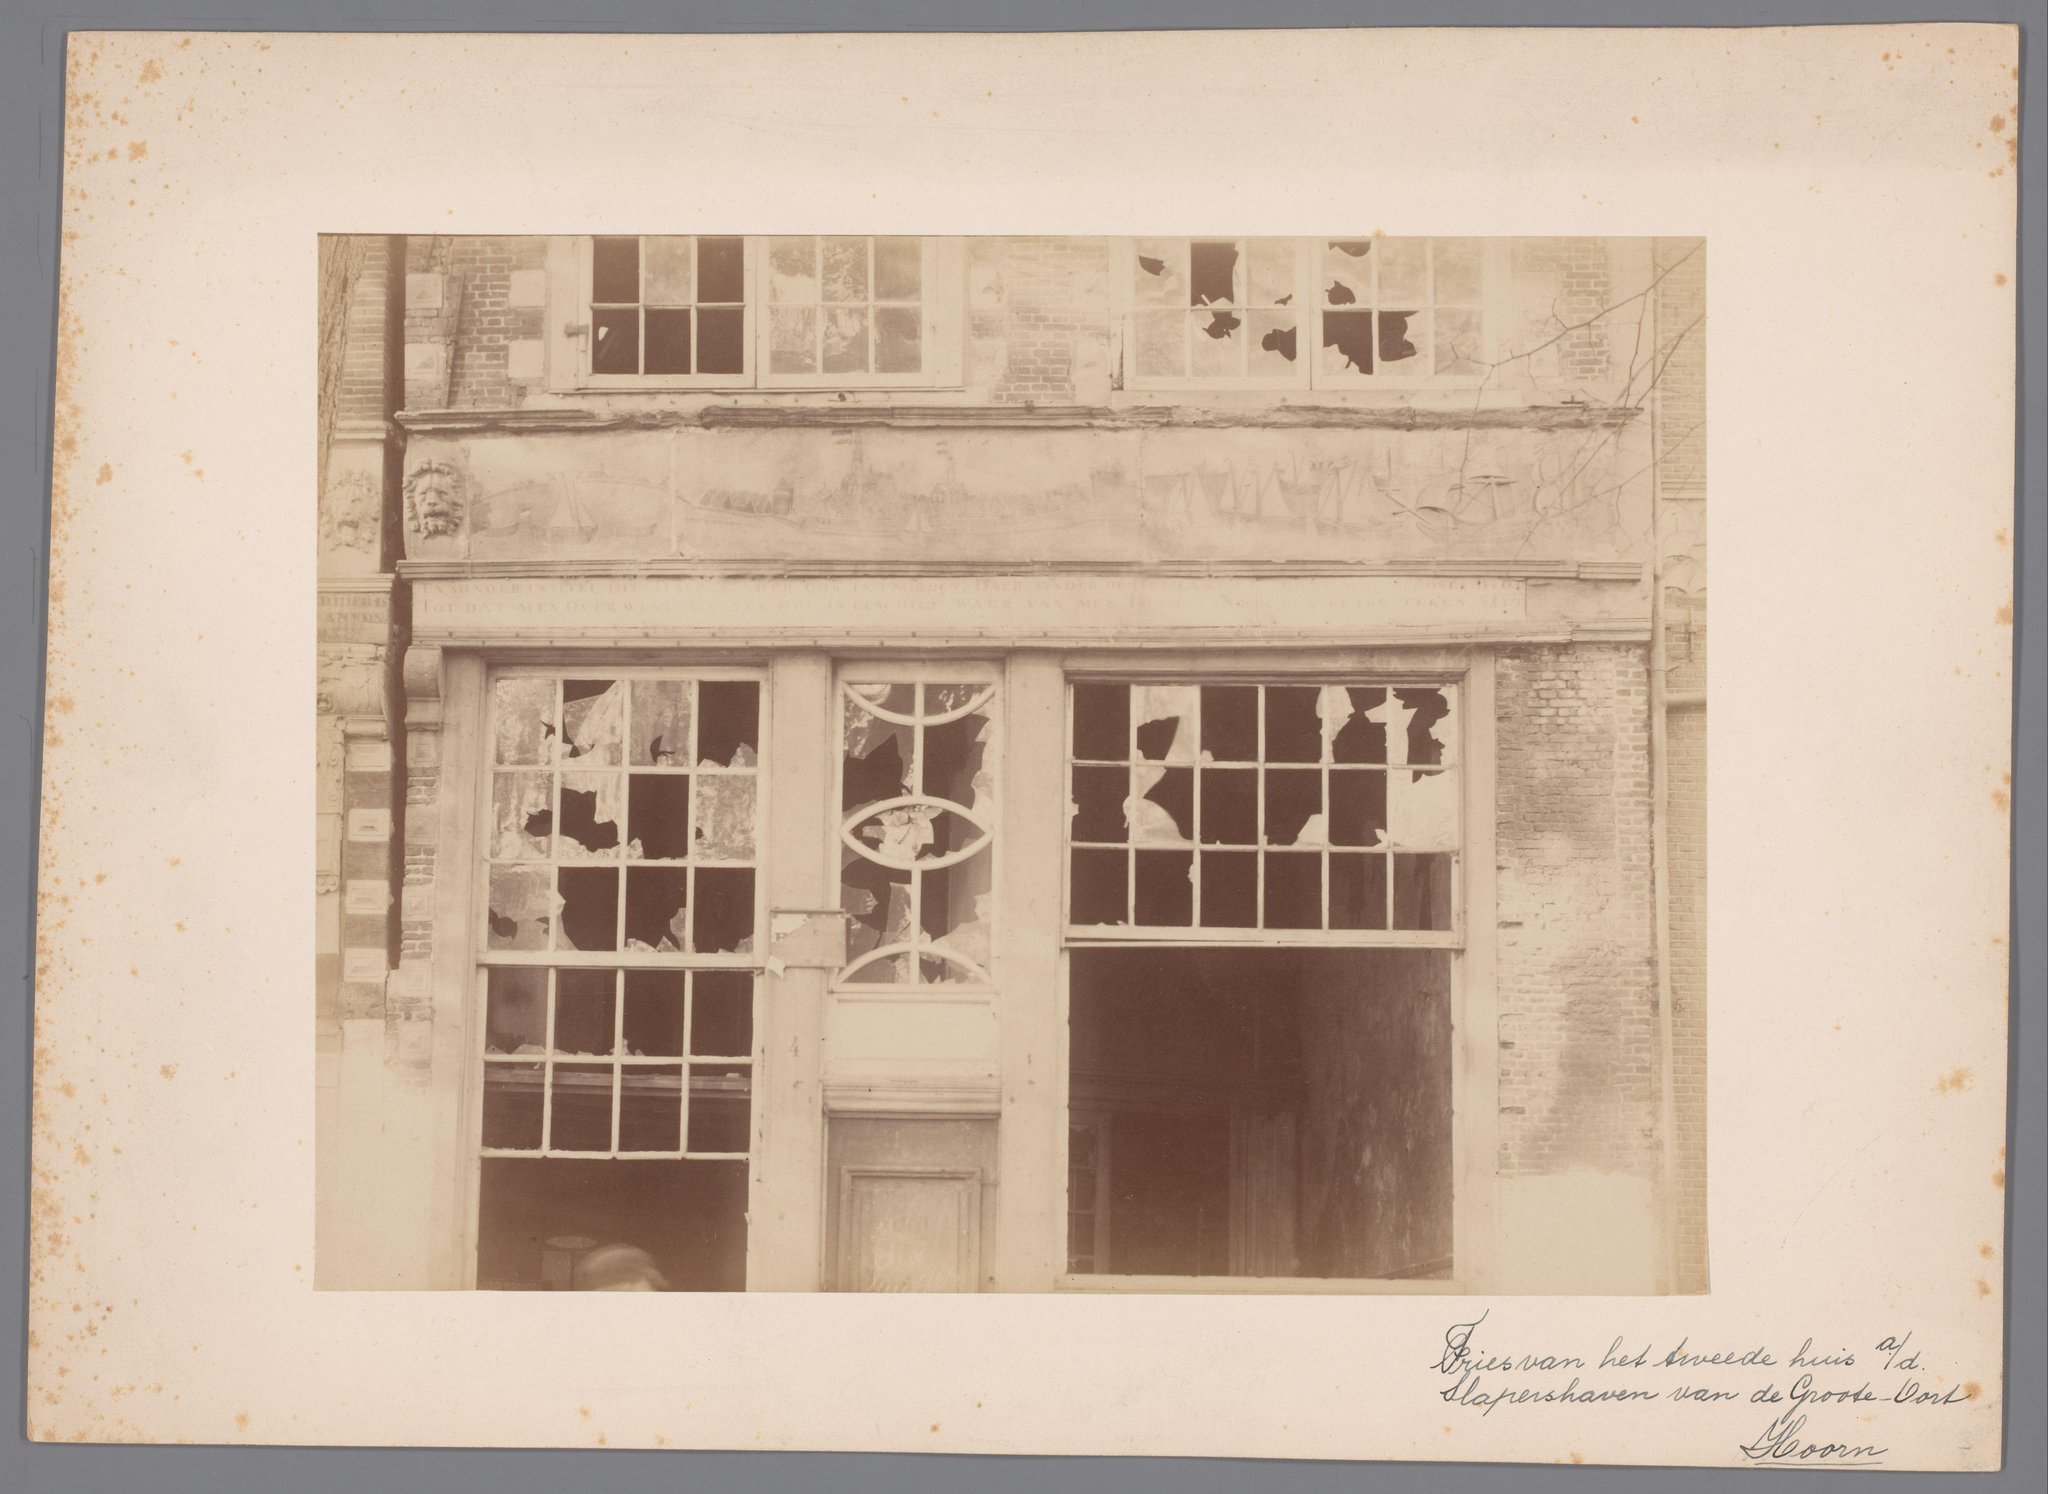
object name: photograph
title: Fries op de gevel van Slapershaven 1 te Hoorn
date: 1893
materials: cardboard, photographic support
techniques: albumen print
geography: hoorn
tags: urban housing, piece of sculpture, reproduction of a piece of sculpture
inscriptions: annotation: ‘Hoorn (N.H.)/ Fries a/h tweede huis a/d/ Slapershaven van af de Groote-Oost/ Nov. 1890’, annotation: ‘Fries van het tweede huis a/d. Slapershaven van de Groote-Oost/ Hoorn’